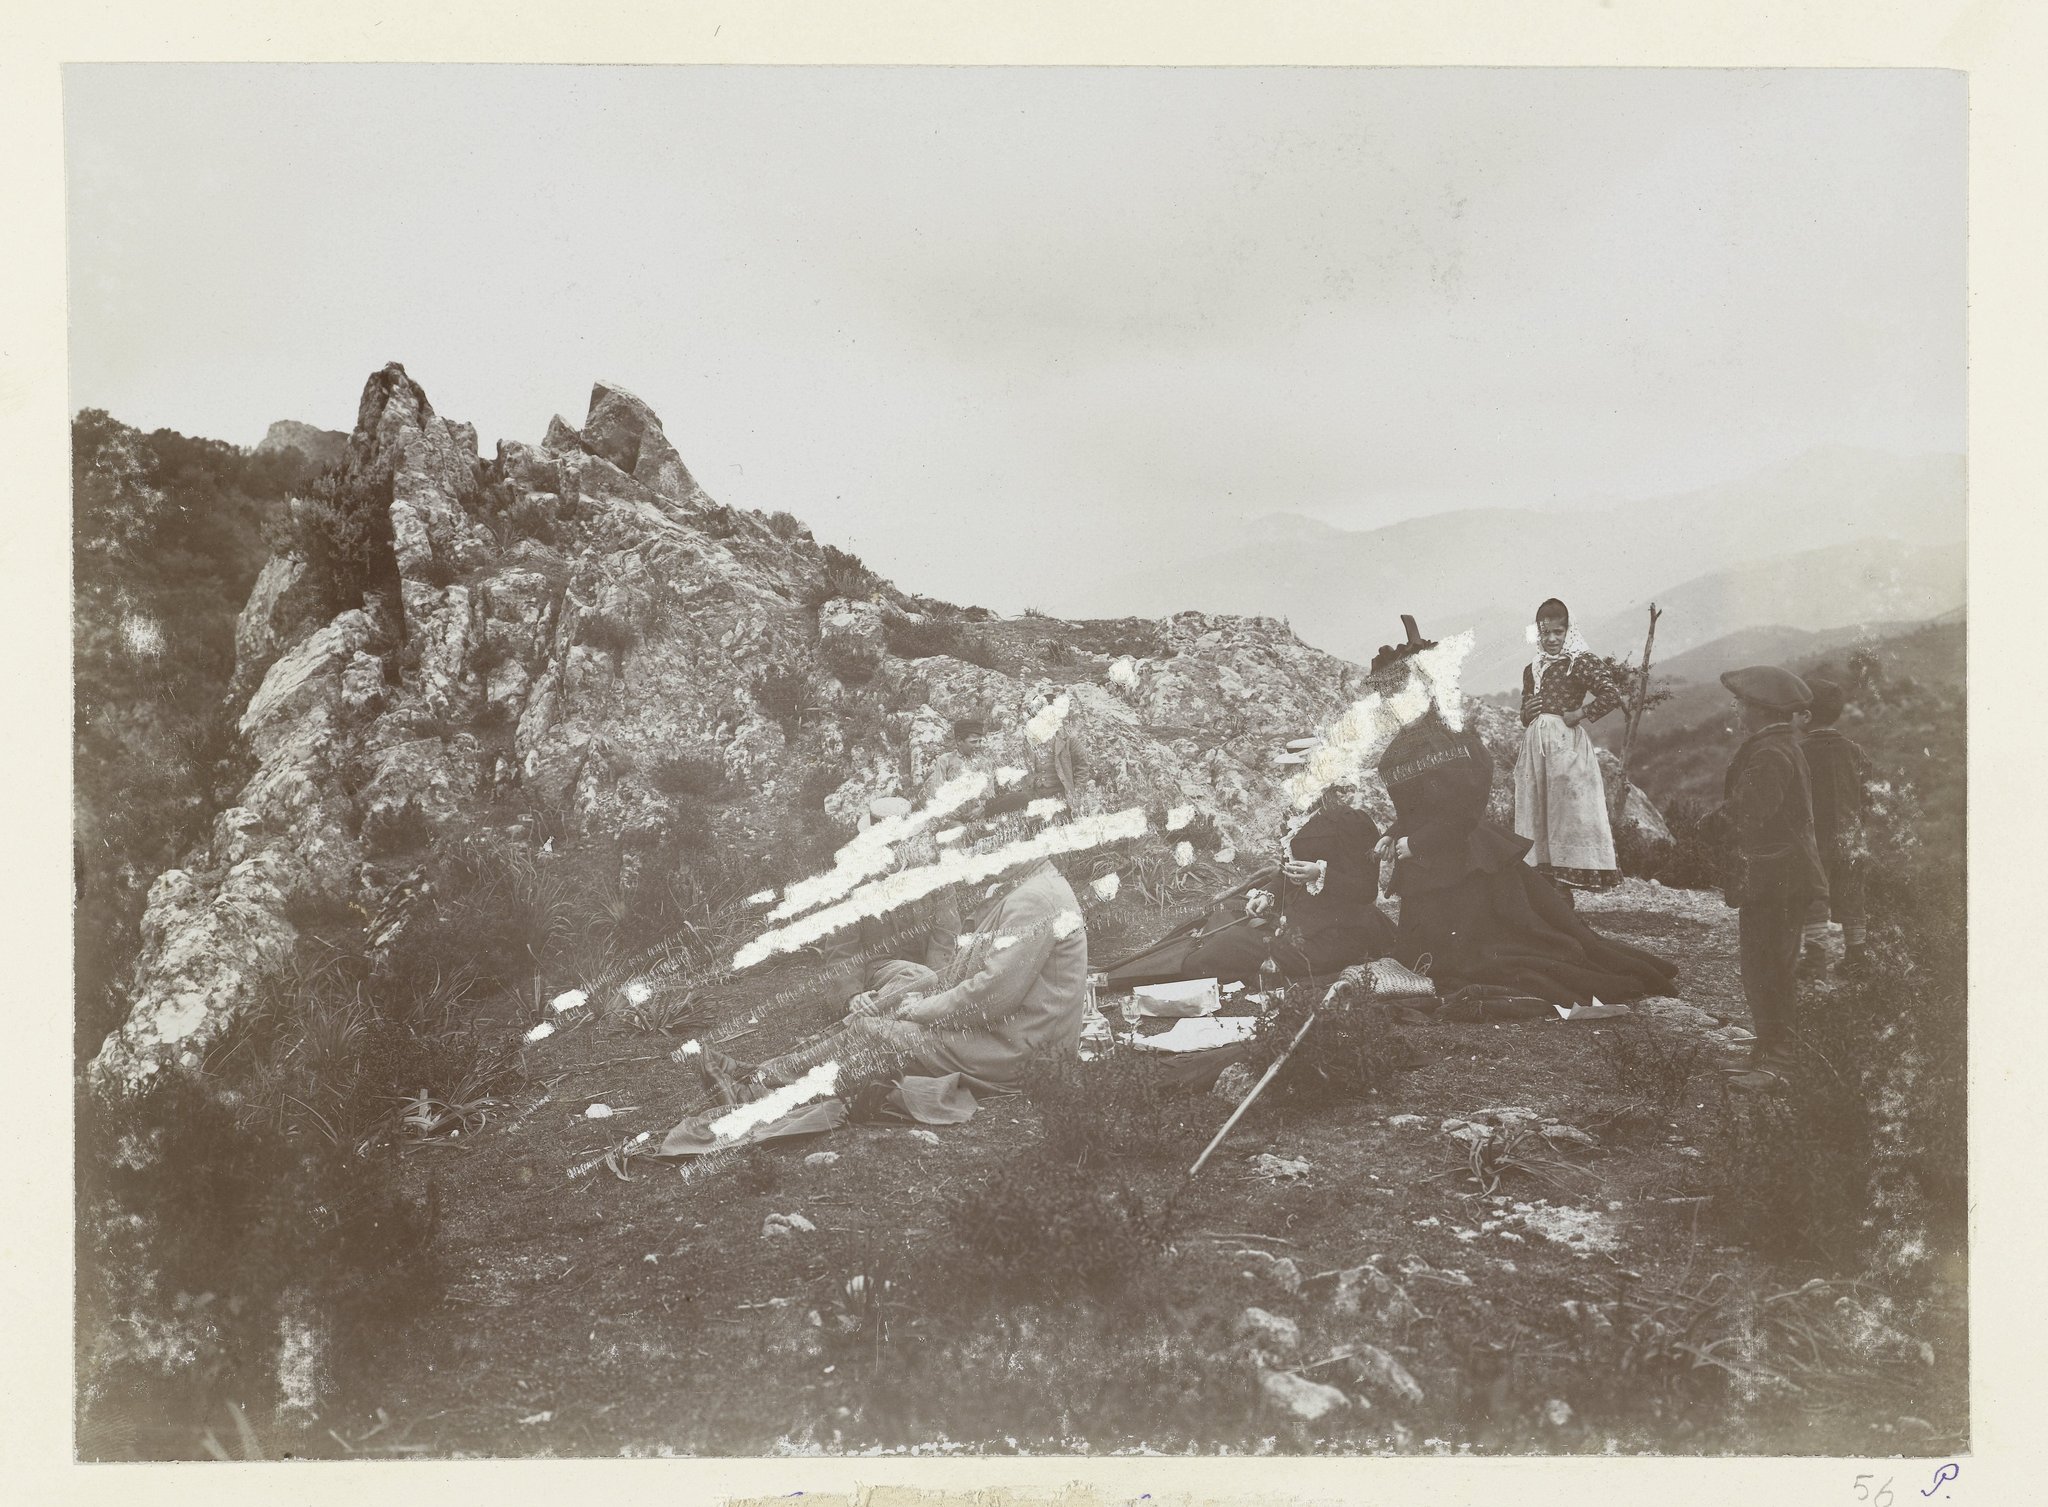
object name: photograph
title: Picknickende mensen in het Corsicaanse berglandschap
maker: henry pauw van wieldrecht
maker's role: fotograaf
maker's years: 1863-1912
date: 1886-1896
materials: cardboard, photographic support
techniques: albumen print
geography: corsica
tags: corsica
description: Een aantal picknickende mensen in het Corsicaanse berglandschap. De gezichten van de mensen op de foto zijn weggekrast evenals de titel onder de foto.